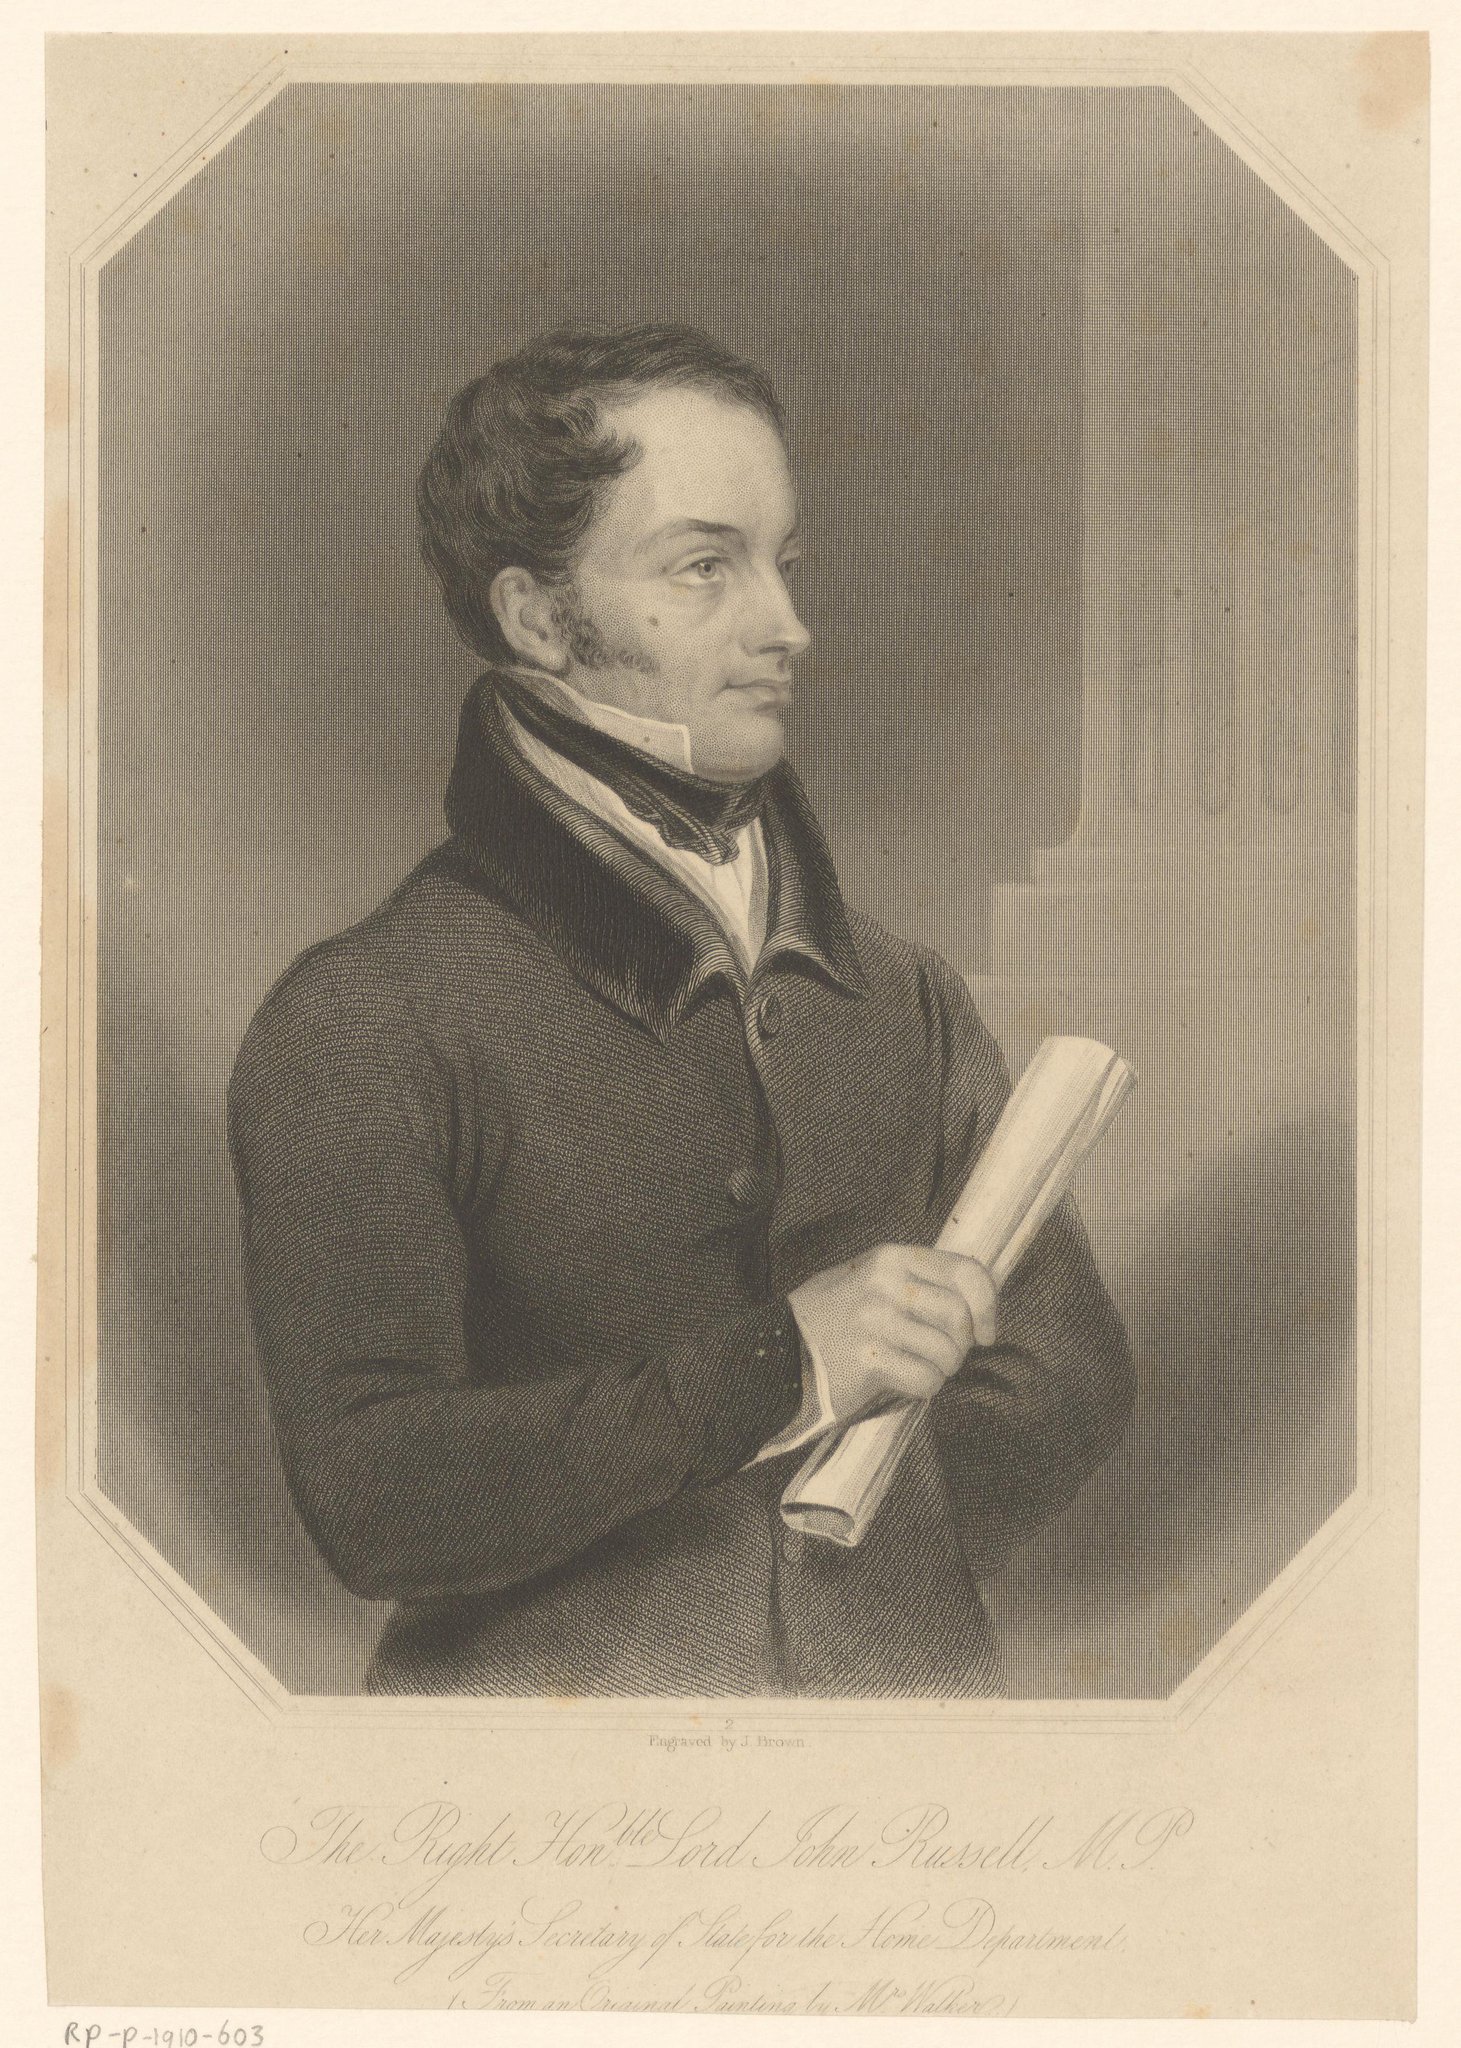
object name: print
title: Portret van John Russell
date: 1835-1839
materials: paper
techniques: engraving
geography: london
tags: politician, historical persons, politician, e.g. party leader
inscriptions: collector's mark: Lugt 2228